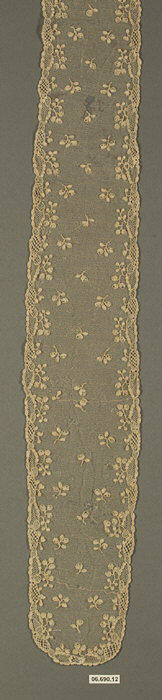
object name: barbe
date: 1701-1800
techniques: lace